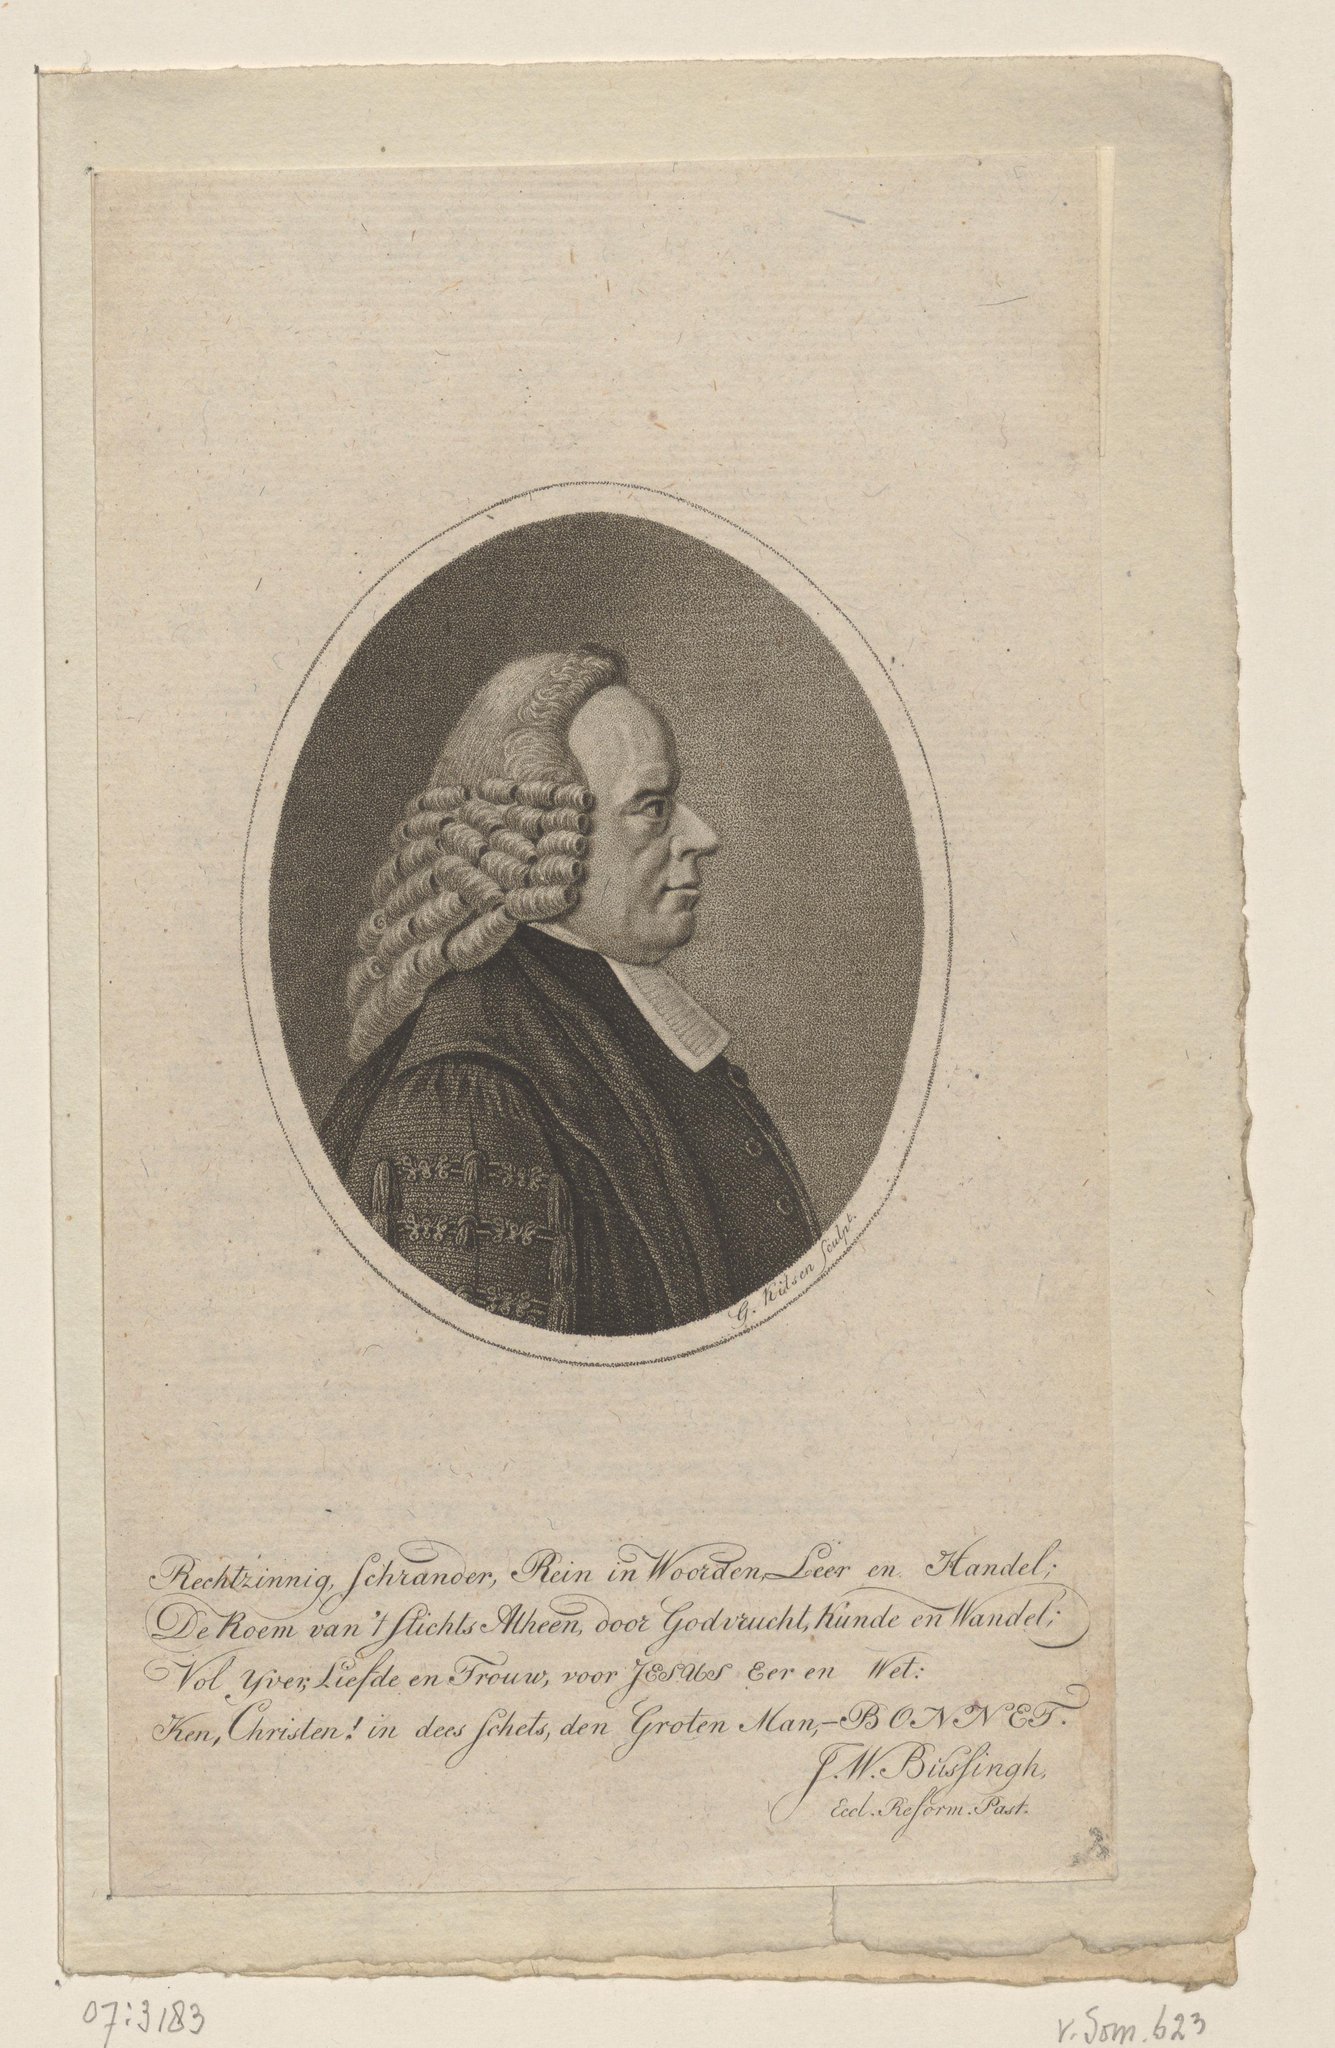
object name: print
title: Portret van Gisbertus Bonnet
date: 1787-1825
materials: paper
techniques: engraving, etching, letterpress printing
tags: utrecht, gisbertus bonnet, scholar, philosopher, historical persons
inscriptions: collector's mark: Lugt 2228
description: Het portret is bevestigd op een dubbelgevouwen tekstblad met een 'Bijschrift op de afbeelding van den hoog-eerwaardigen en hoog-geleerden heer Gysbertus Bonnet' en een 'Epigramma in effigiem V. CL. Gysberti Bonnet'.